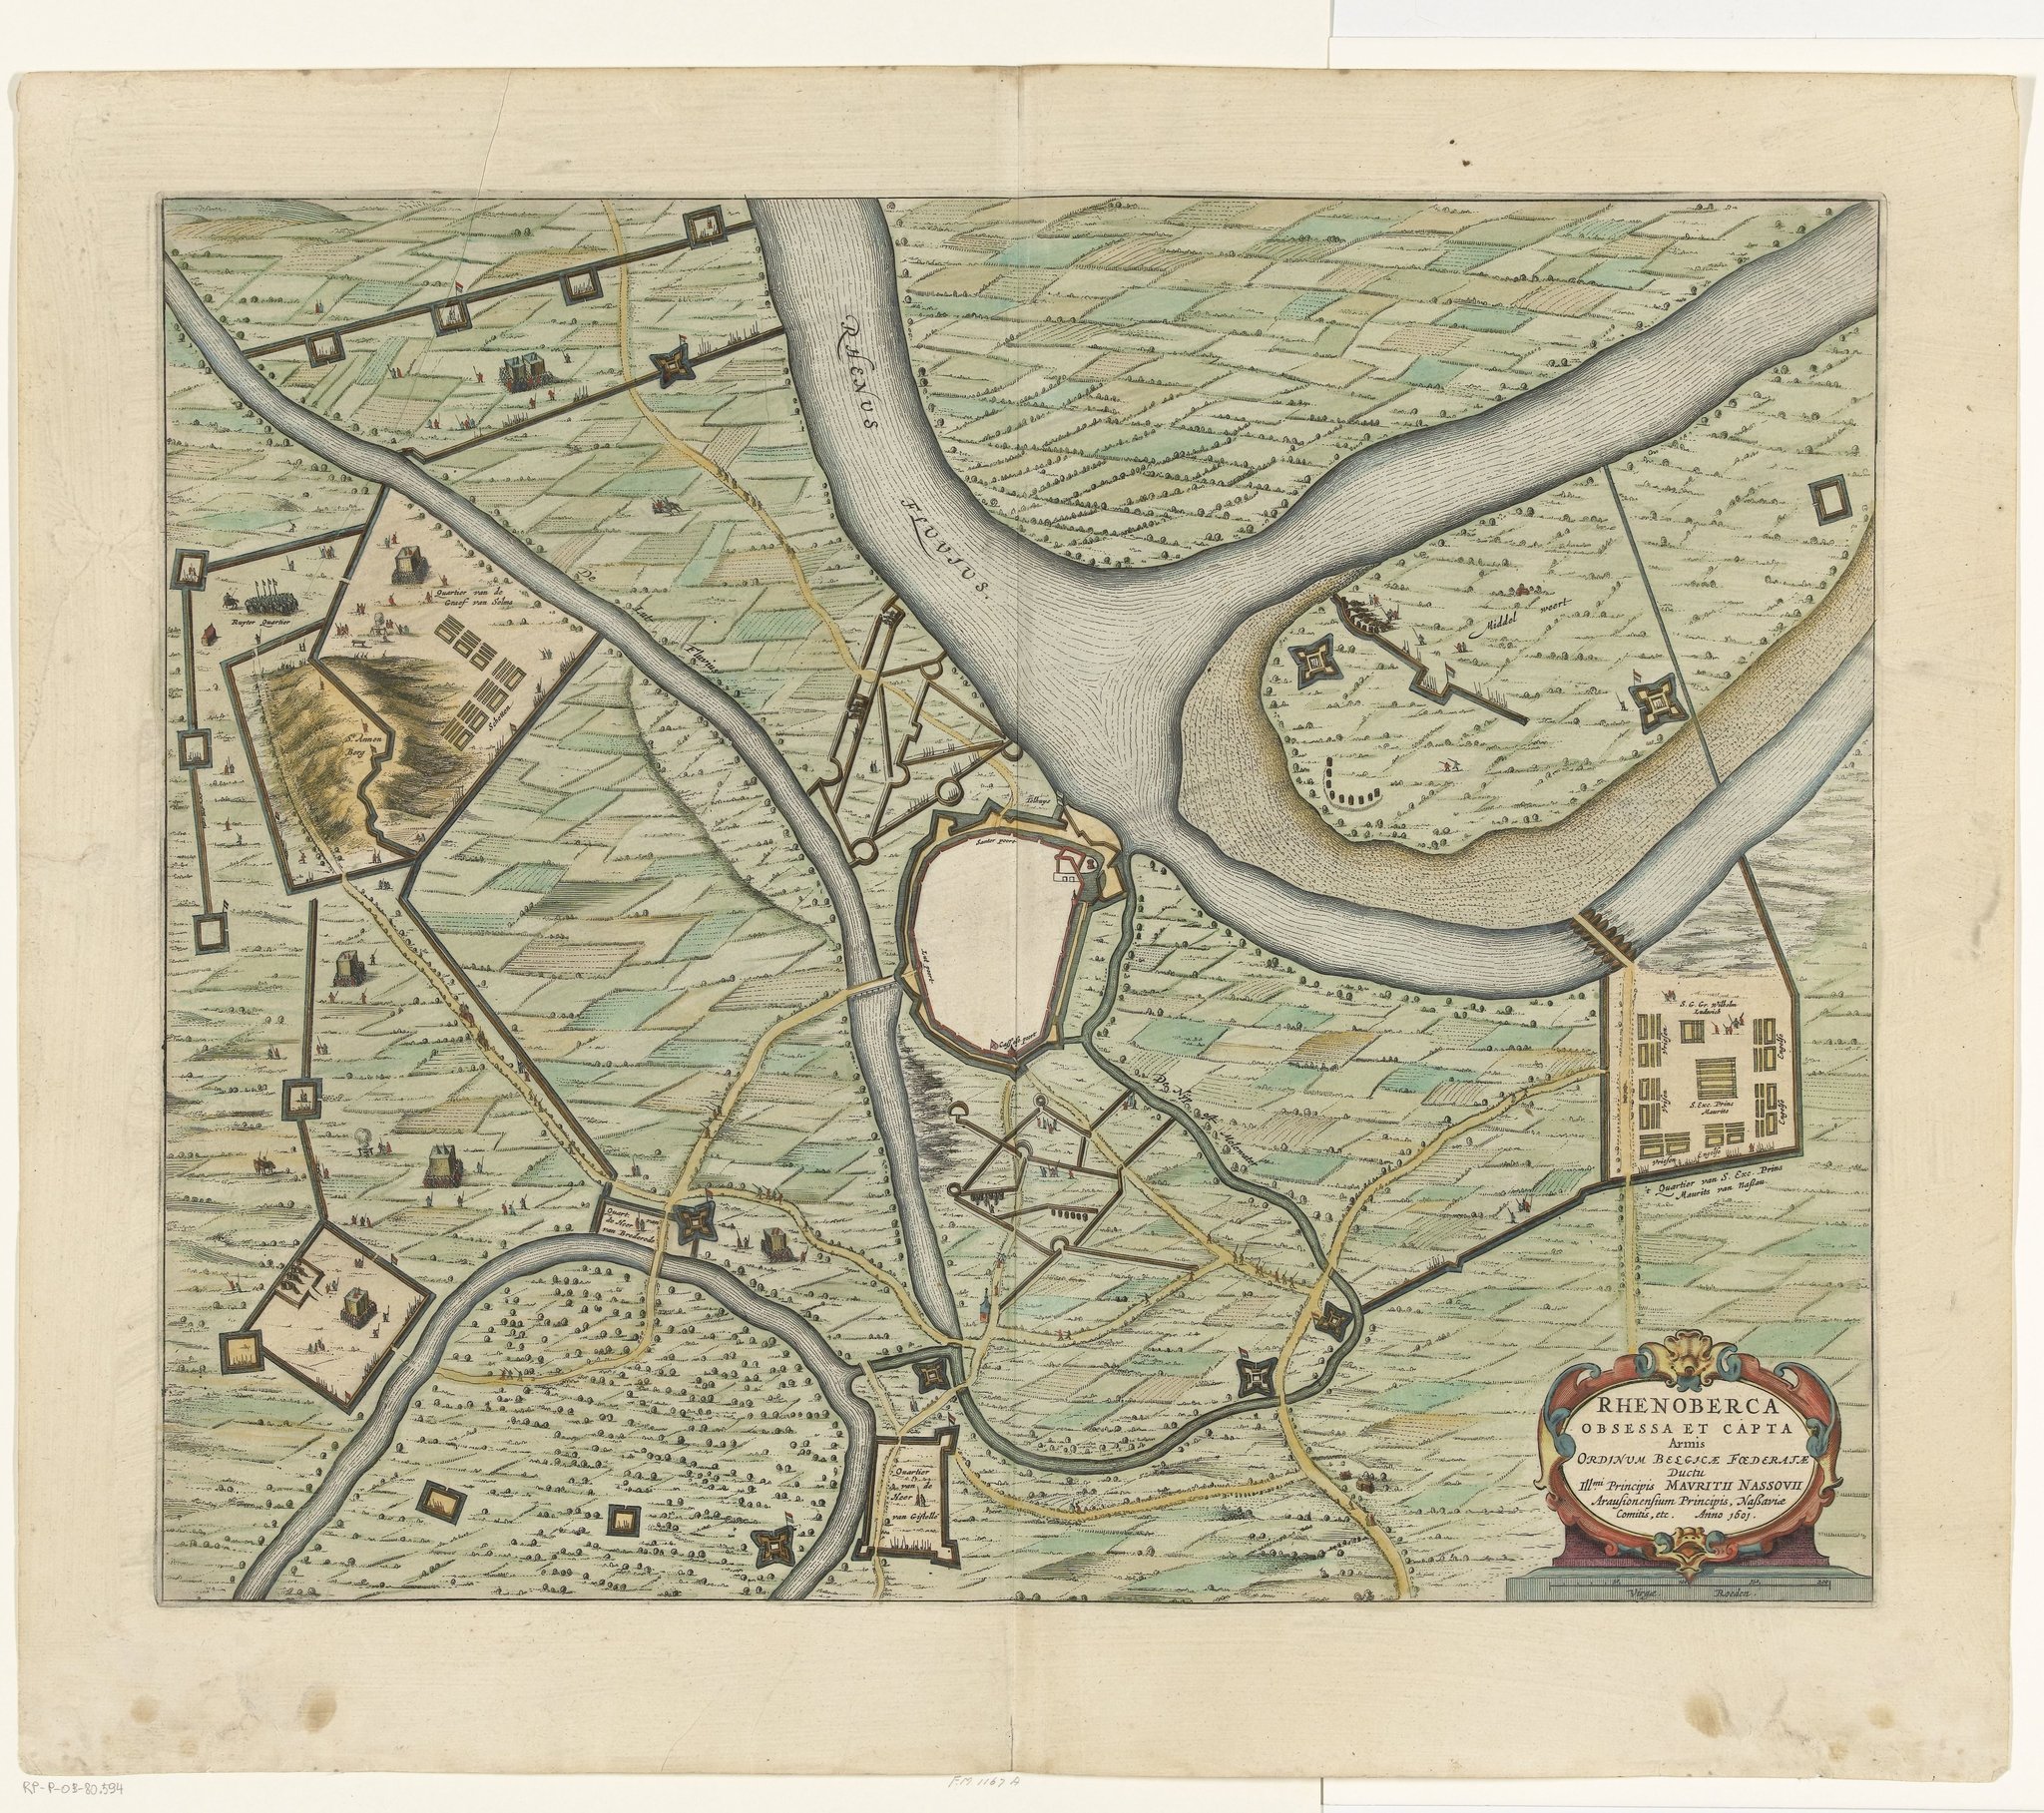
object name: print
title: 't Belegh van Rhynberck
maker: Anonymous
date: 1647-1649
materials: paper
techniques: engraving, etching, hand coloring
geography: northern netherlands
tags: the hague, maurice (prince of orange), maps of separate countries or regions, siege, position war, capture of city (after the siege)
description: Kaart van de stad Rheinberg en het omliggende land tijdens de belegering vanaf 12 juni en verovering op 31 juli 1601 door het Staatse leger onder prins Maurits. Plan van de verdedigingswerken van de stad en in het omliggende land, met de legerkampen van de belegeraars. Bovenaan de Rijn. Rechtsonder een cartouche met de titel in het Latijn. Dubbelblad genomen uit het Stedenboek van Blaeu, bedrukt op achterzijde met tekst in het Nederlands.